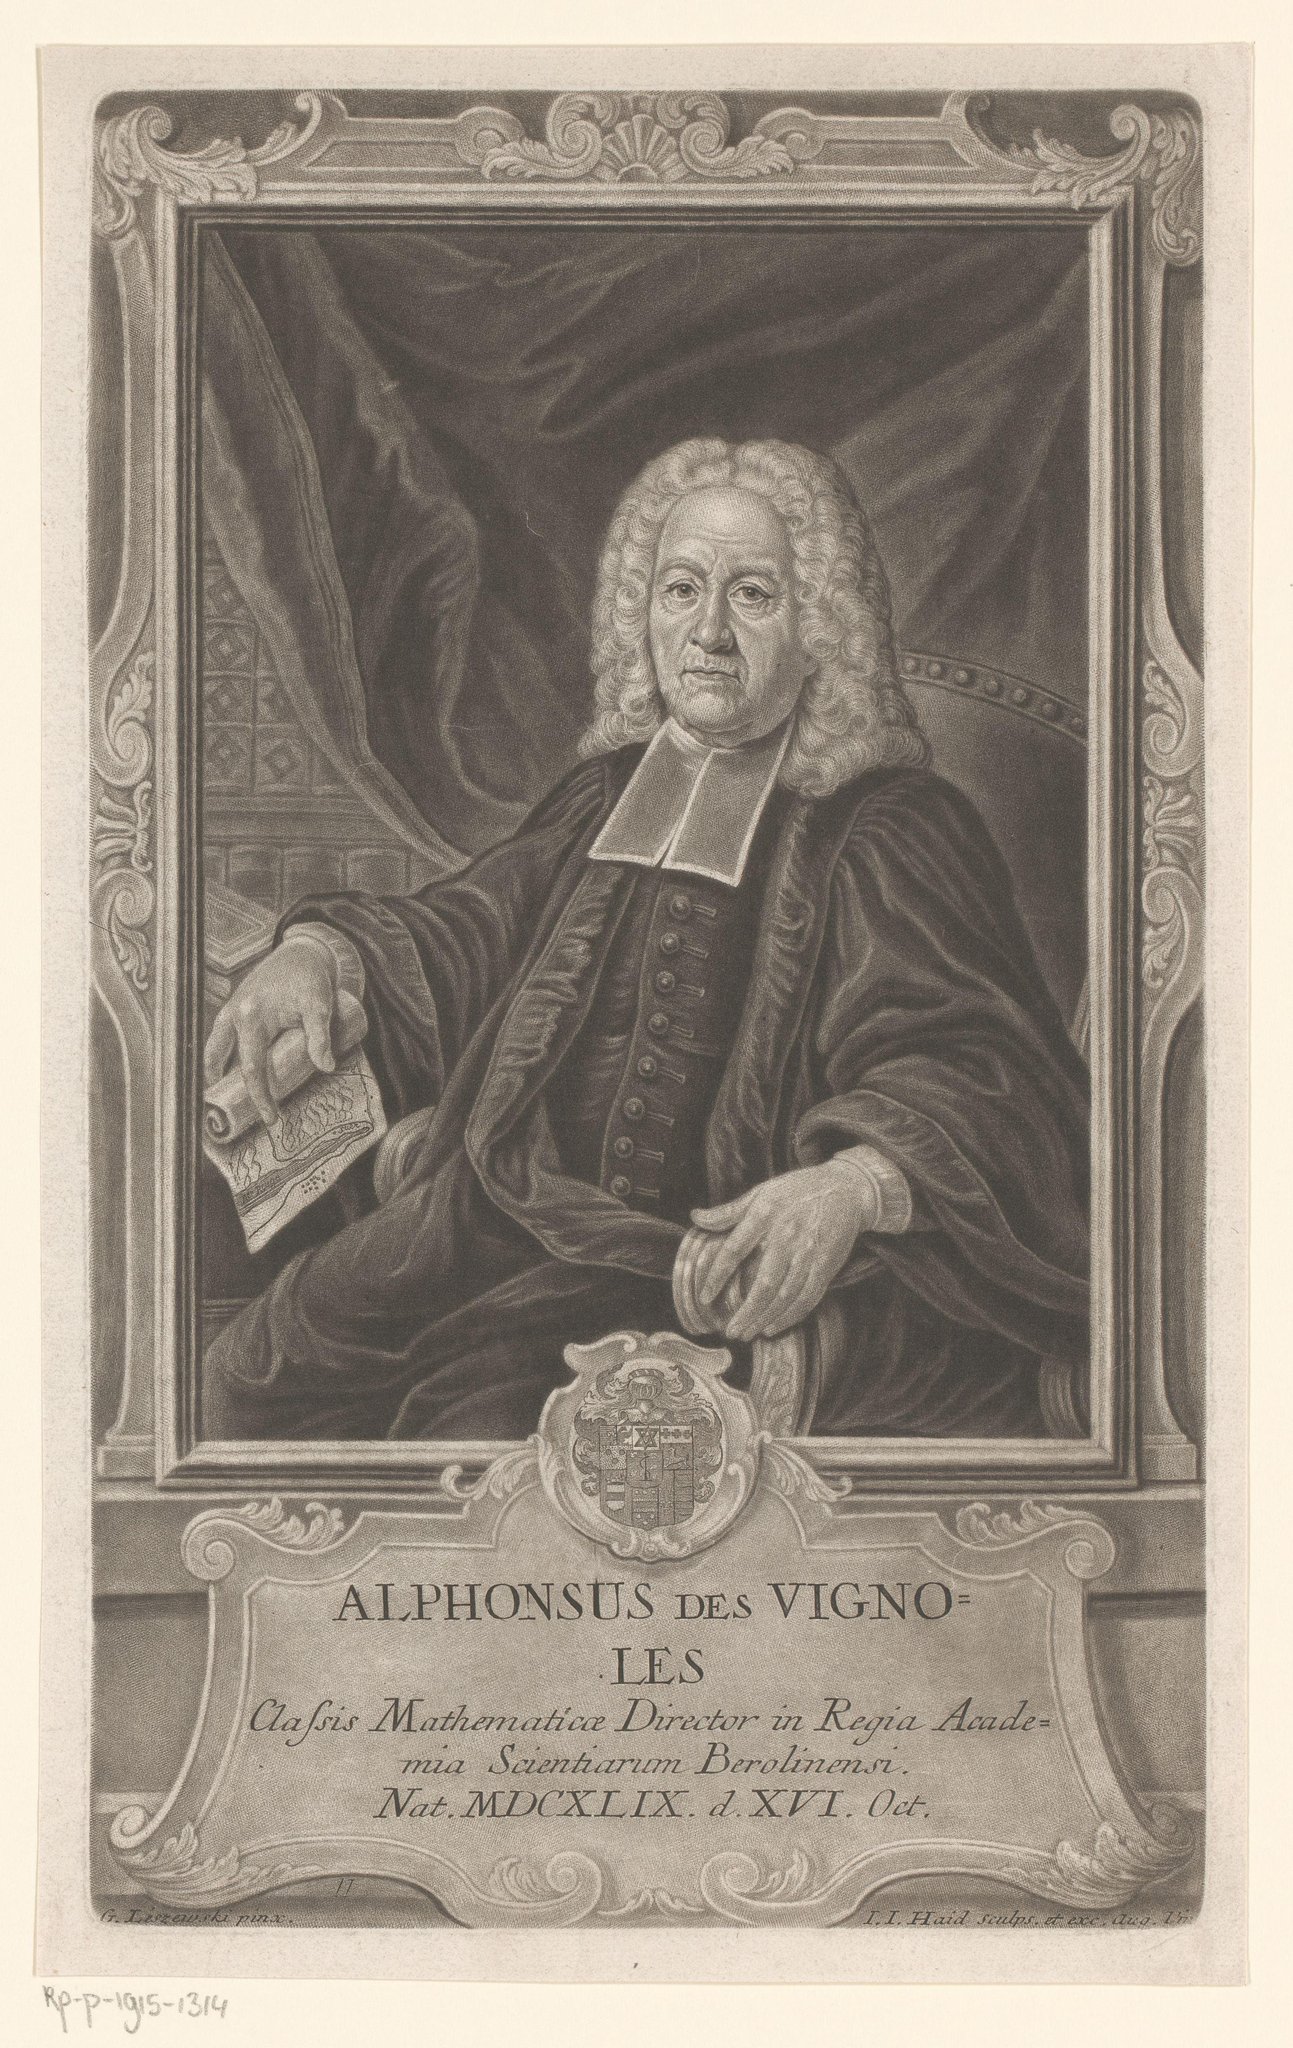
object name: print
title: Portret van Alphonse des Vignolles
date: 1714-1744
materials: paper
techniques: etching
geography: augsburg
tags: berlin, clergyman, bookshelves, historical persons, ornament ~ cartouche, scroll, armorial bearing, heraldry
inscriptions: collector's mark: Lugt 2228